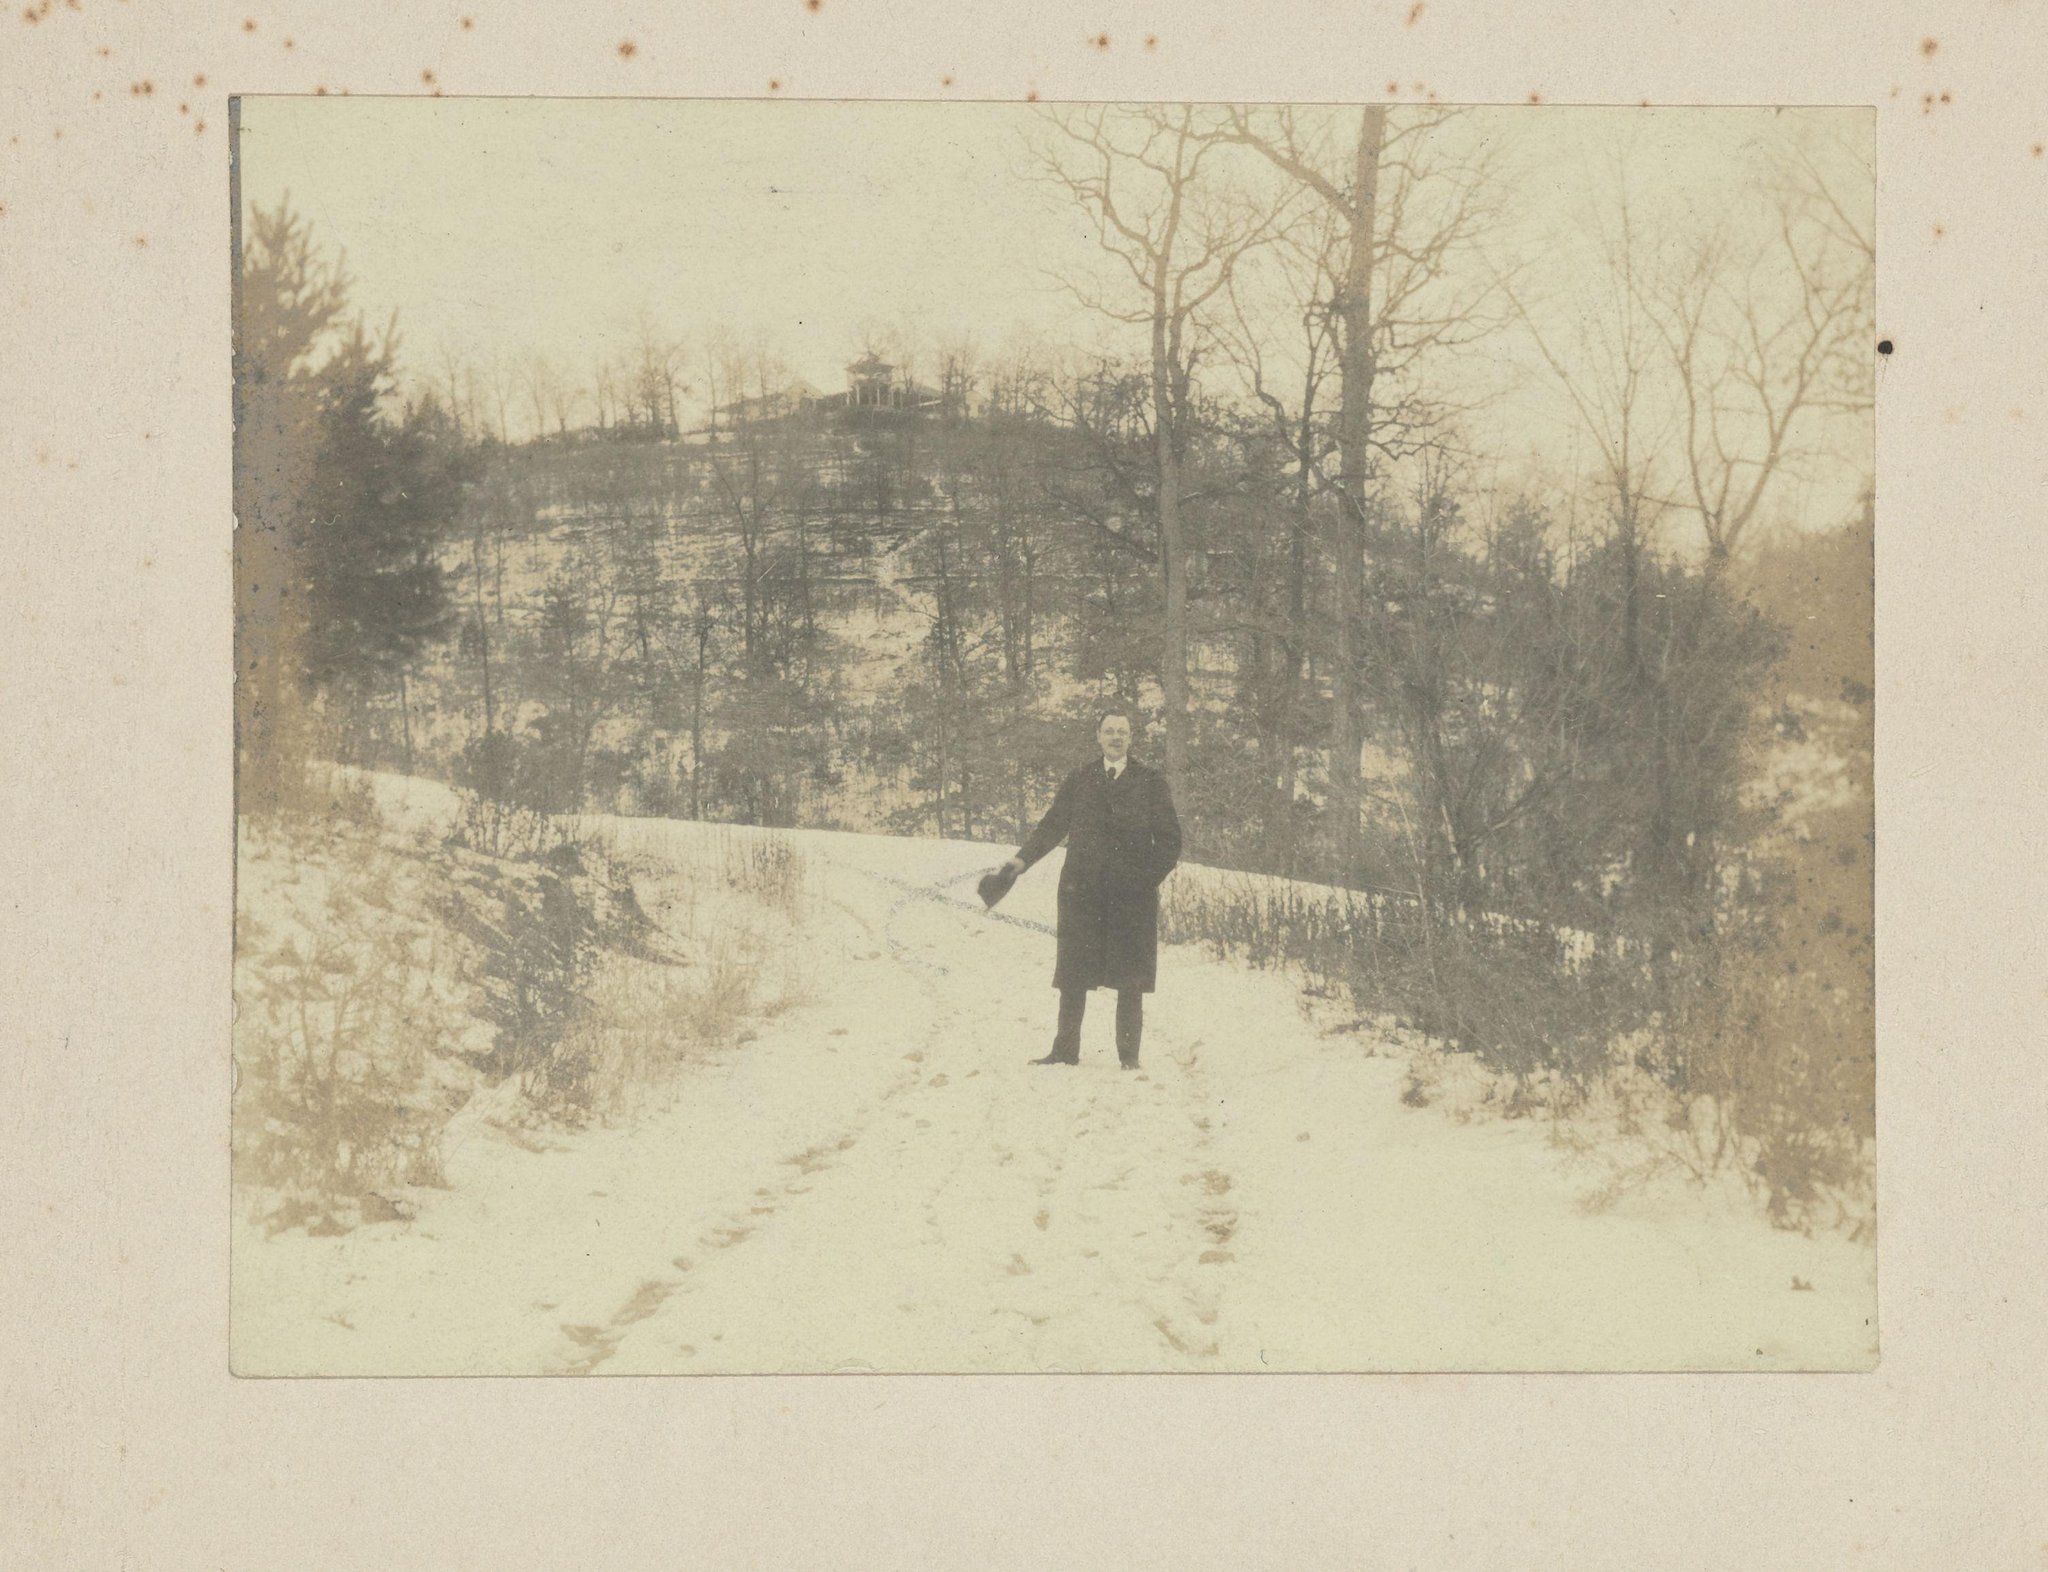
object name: photograph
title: Jan C. Schüller tussen een paar heuvels in de Meramec Highlands tijdens de wereldtentoonstelling in St. Louis (Louisiana Purchase Exposition), 1904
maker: Anonymous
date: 1904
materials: cardboard, paper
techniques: gelatin silver print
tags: painter, print maker, draughtsman, jan schüller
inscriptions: annotation: ‘Tusschen een paar heuvels // Meramec Highland’, annotation: ‘Jan C. Schüller’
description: Jan C. Schüller tussen een paar heuvels in de Meramec Highlands tijdens de wereldtentoonstelling in St. Louis (Louisiana Purchase Exposition), 1904.